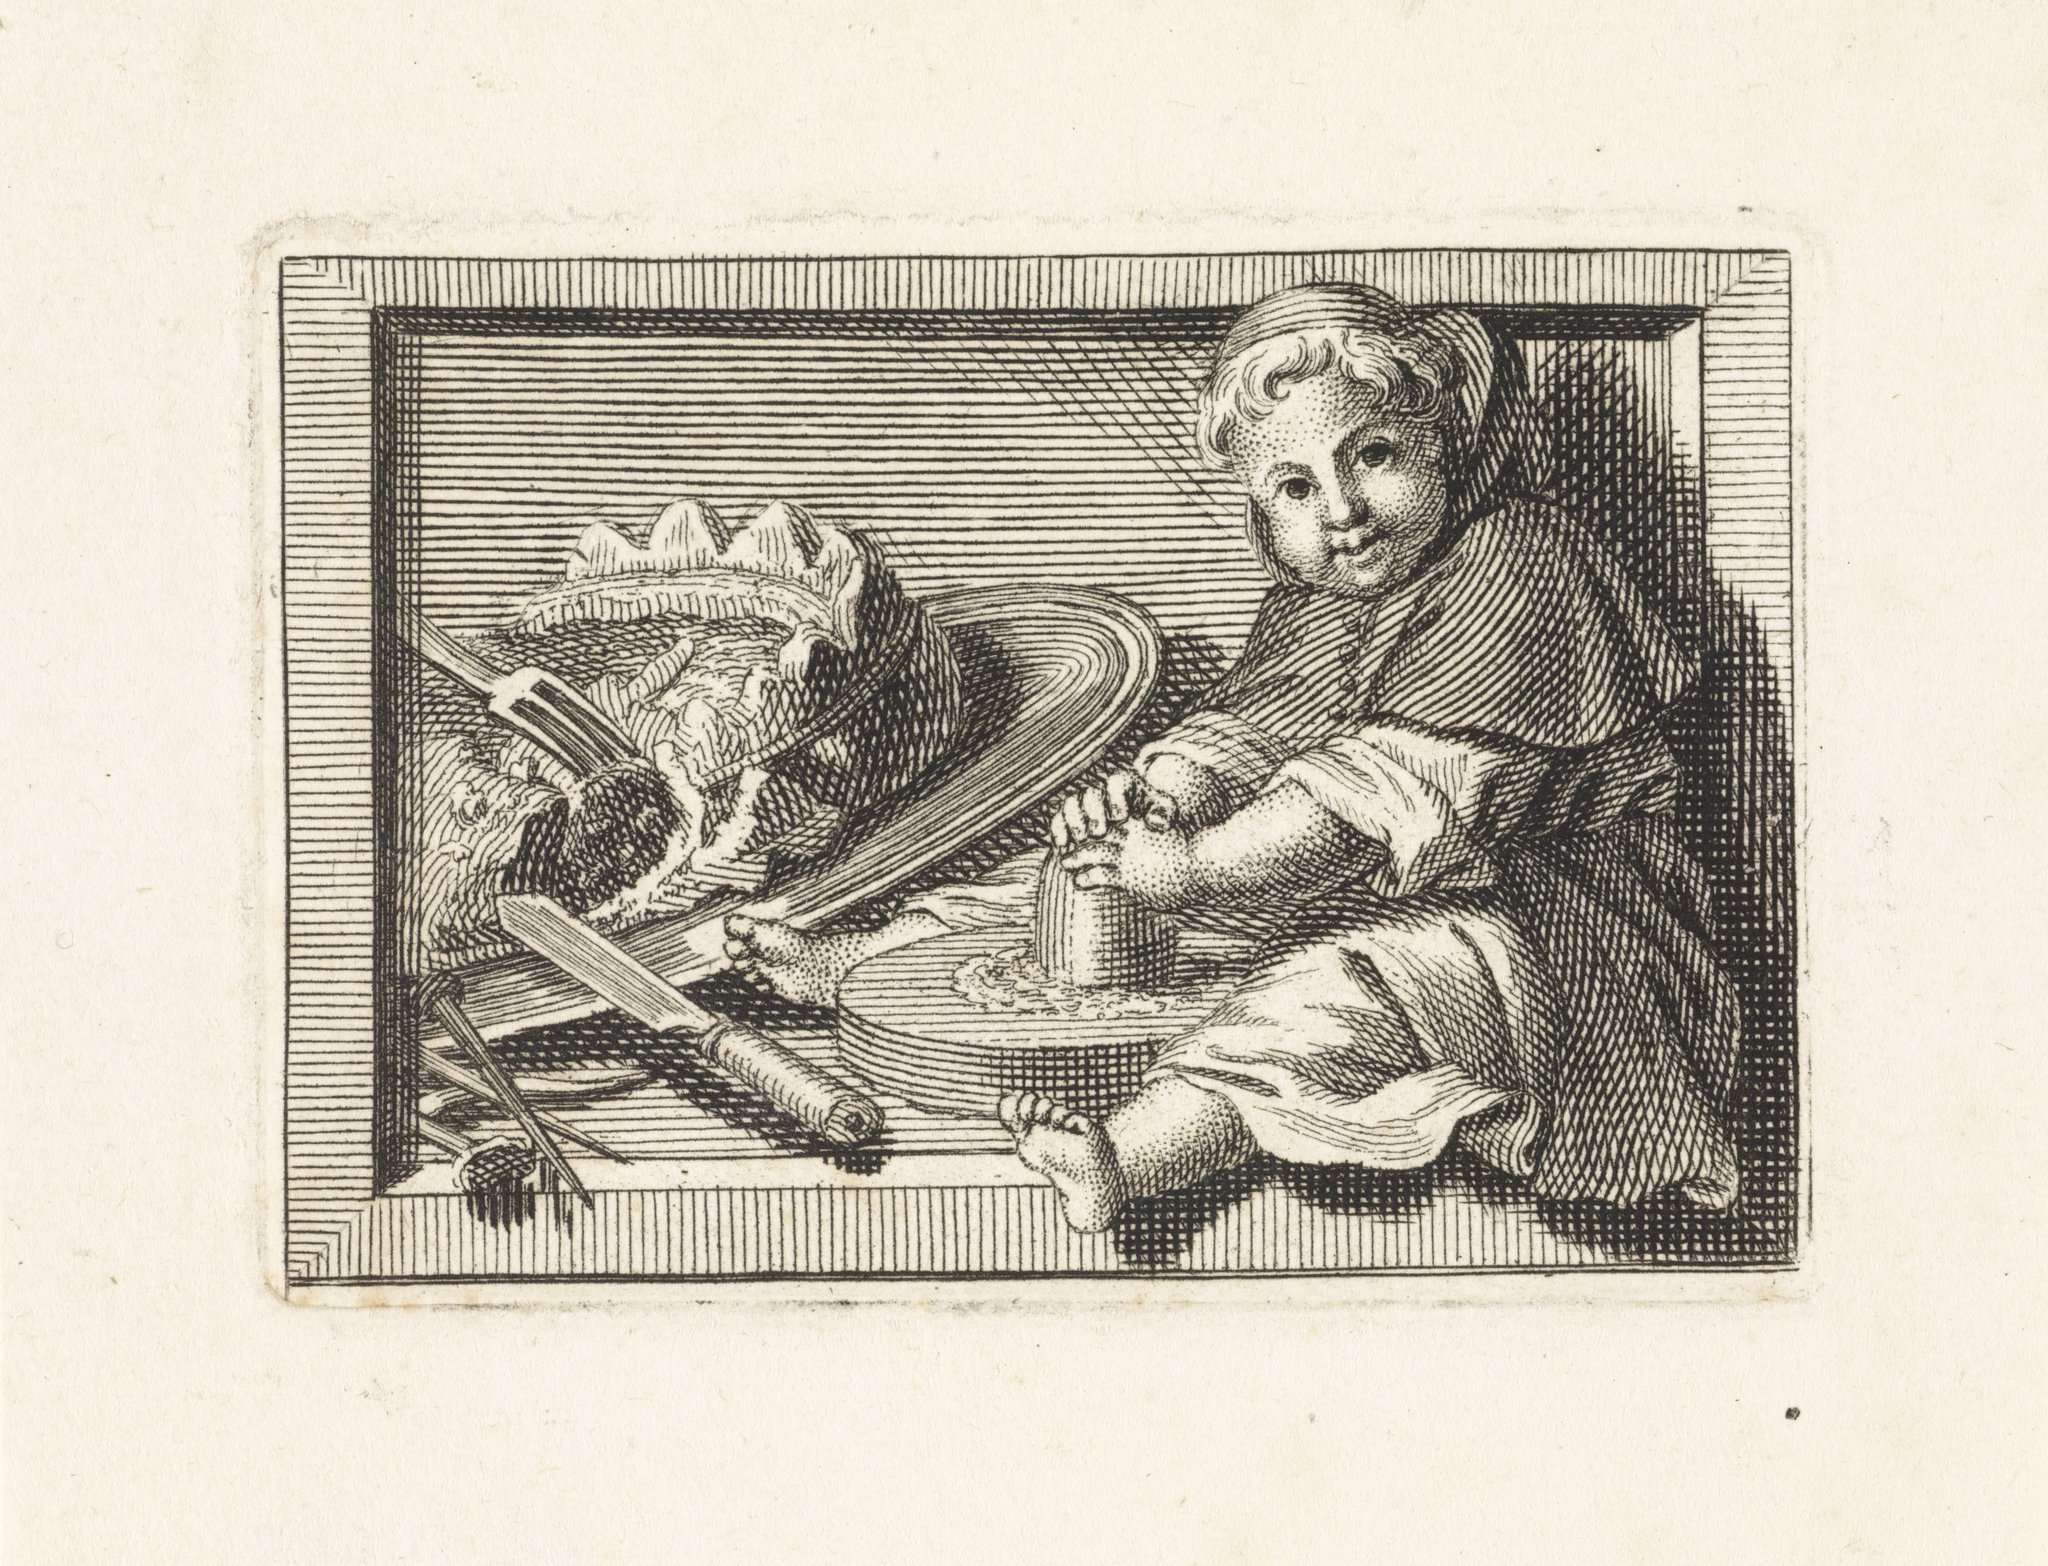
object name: print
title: Putto in de kleding van een geestelijke maalt meel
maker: Anonymous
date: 1683-1783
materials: paper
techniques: engraving, etching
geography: netherlands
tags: organization, functionaries and dignitaries in churches and in related institutions, bread, cake, pastry, etc., grinding, milling (industrial processes)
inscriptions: collector's mark: Lugt 2228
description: Een putto, gekleed als een geestelijke, maalt meel op een steen. Daarnaast een half opgegeten pastei.